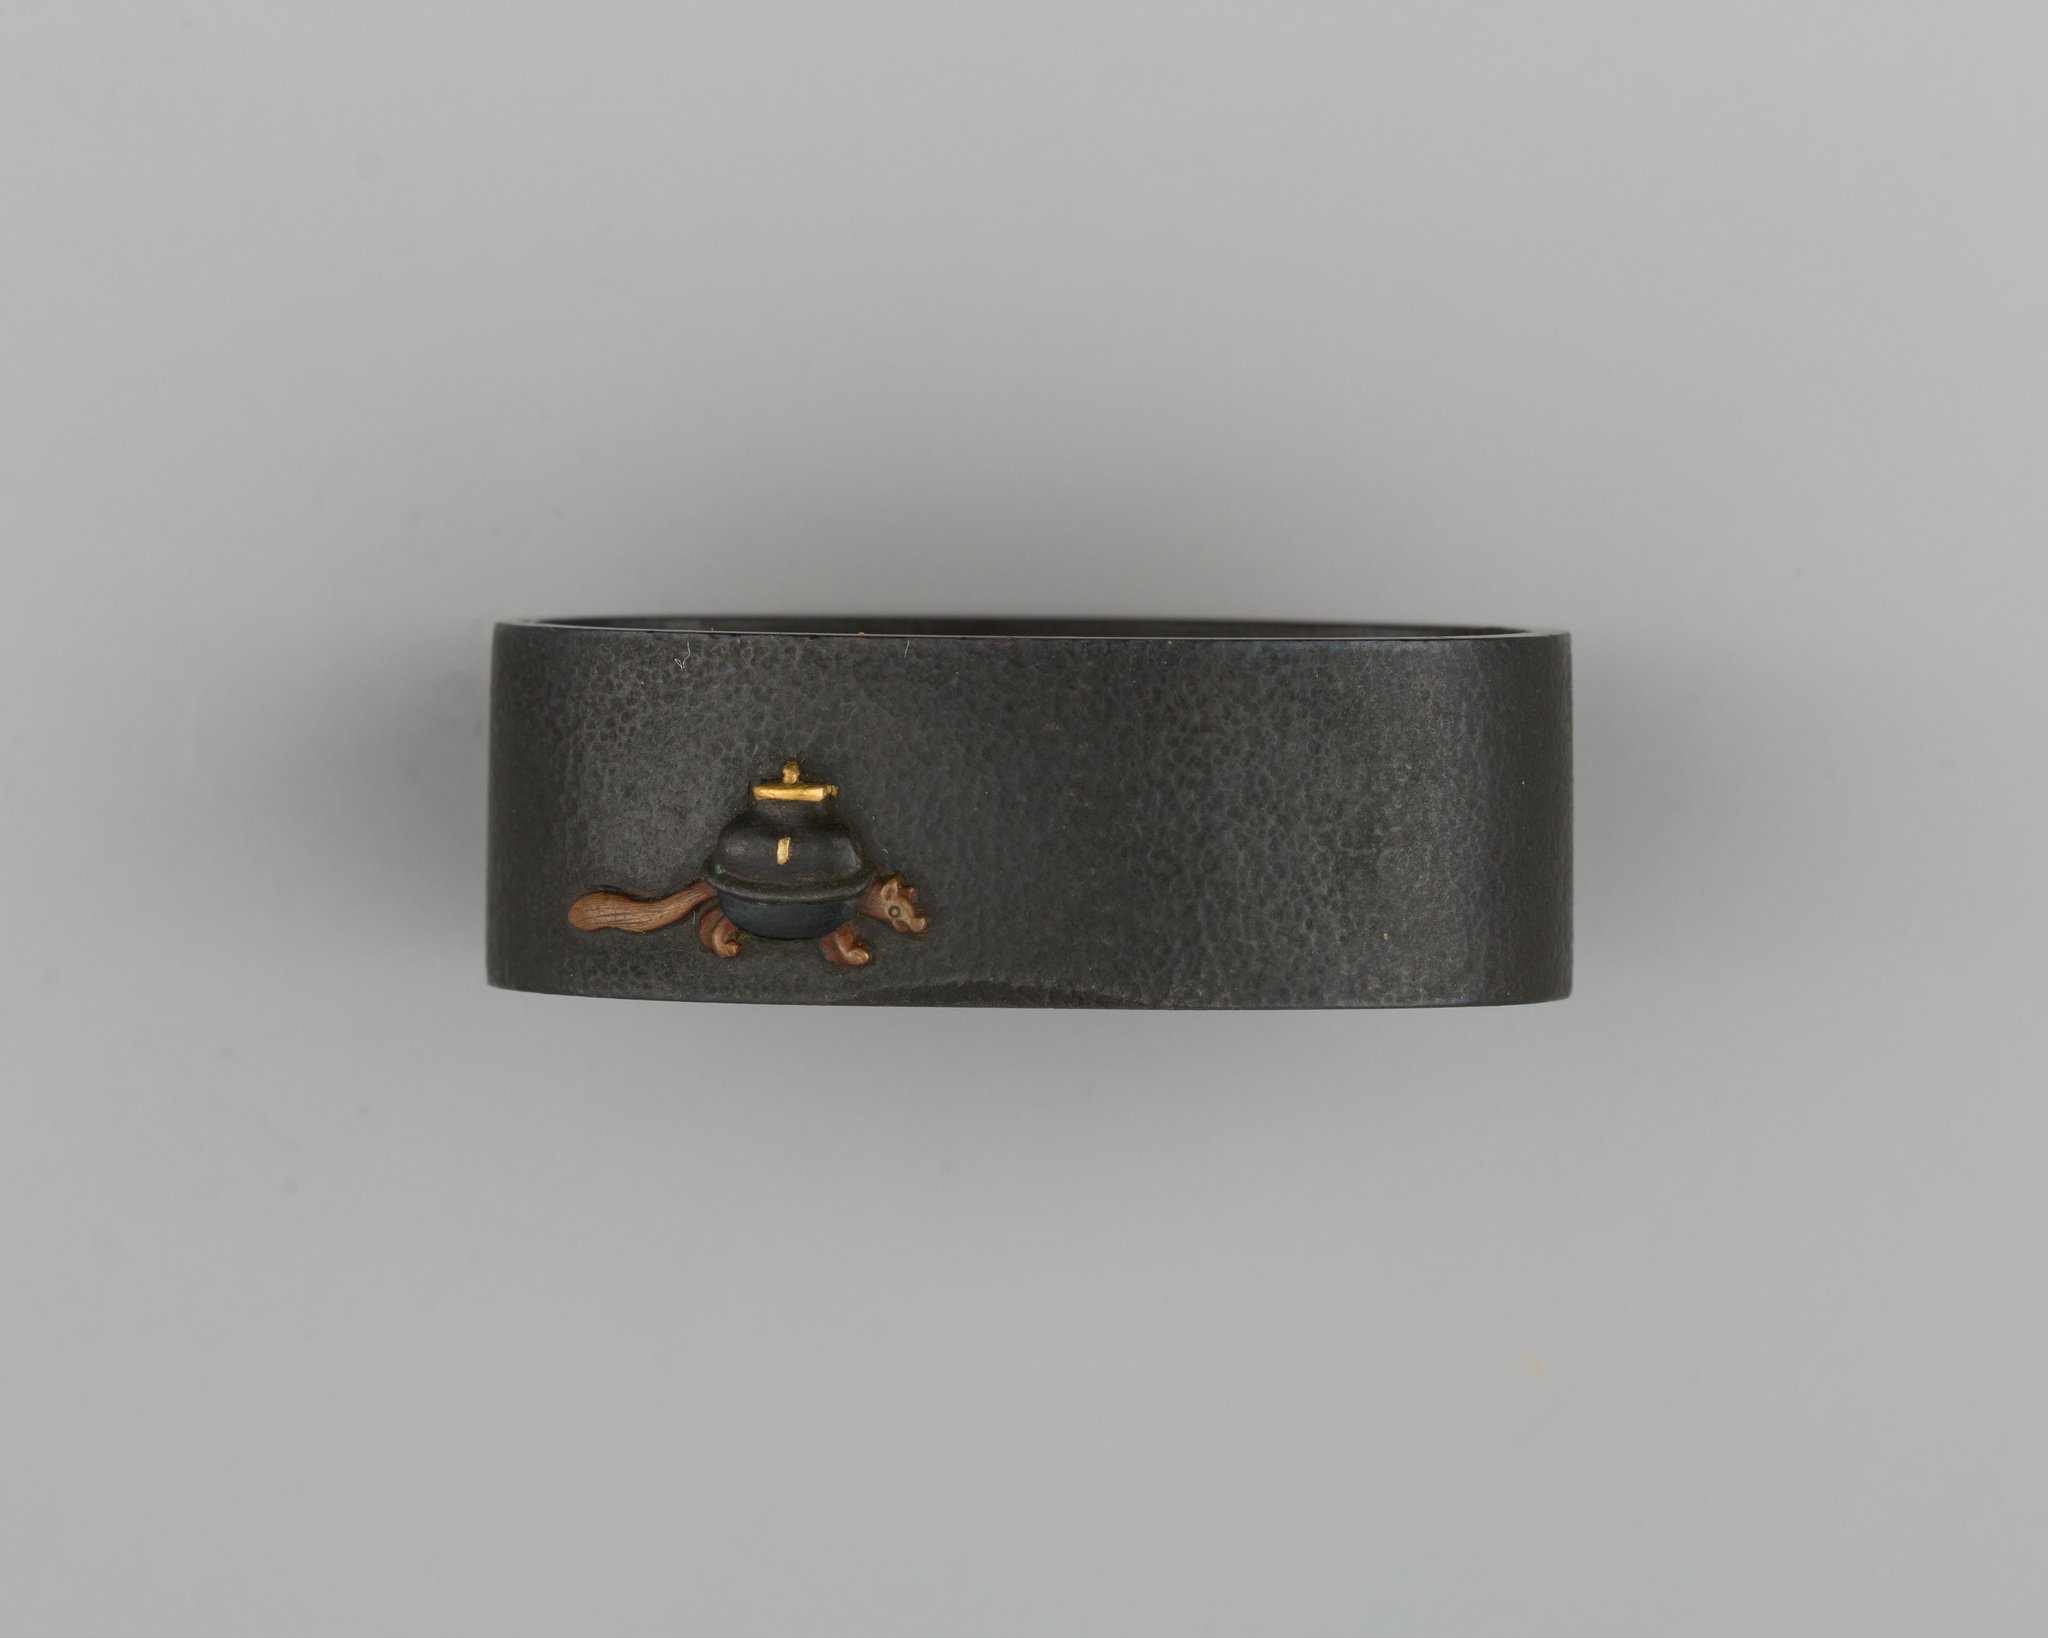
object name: sword hilt collar fuchi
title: Sword-Hilt Collar (Fuchi)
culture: japanese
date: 1615-1868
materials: copper, gold alloy, silver alloy, gold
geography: japan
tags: animals